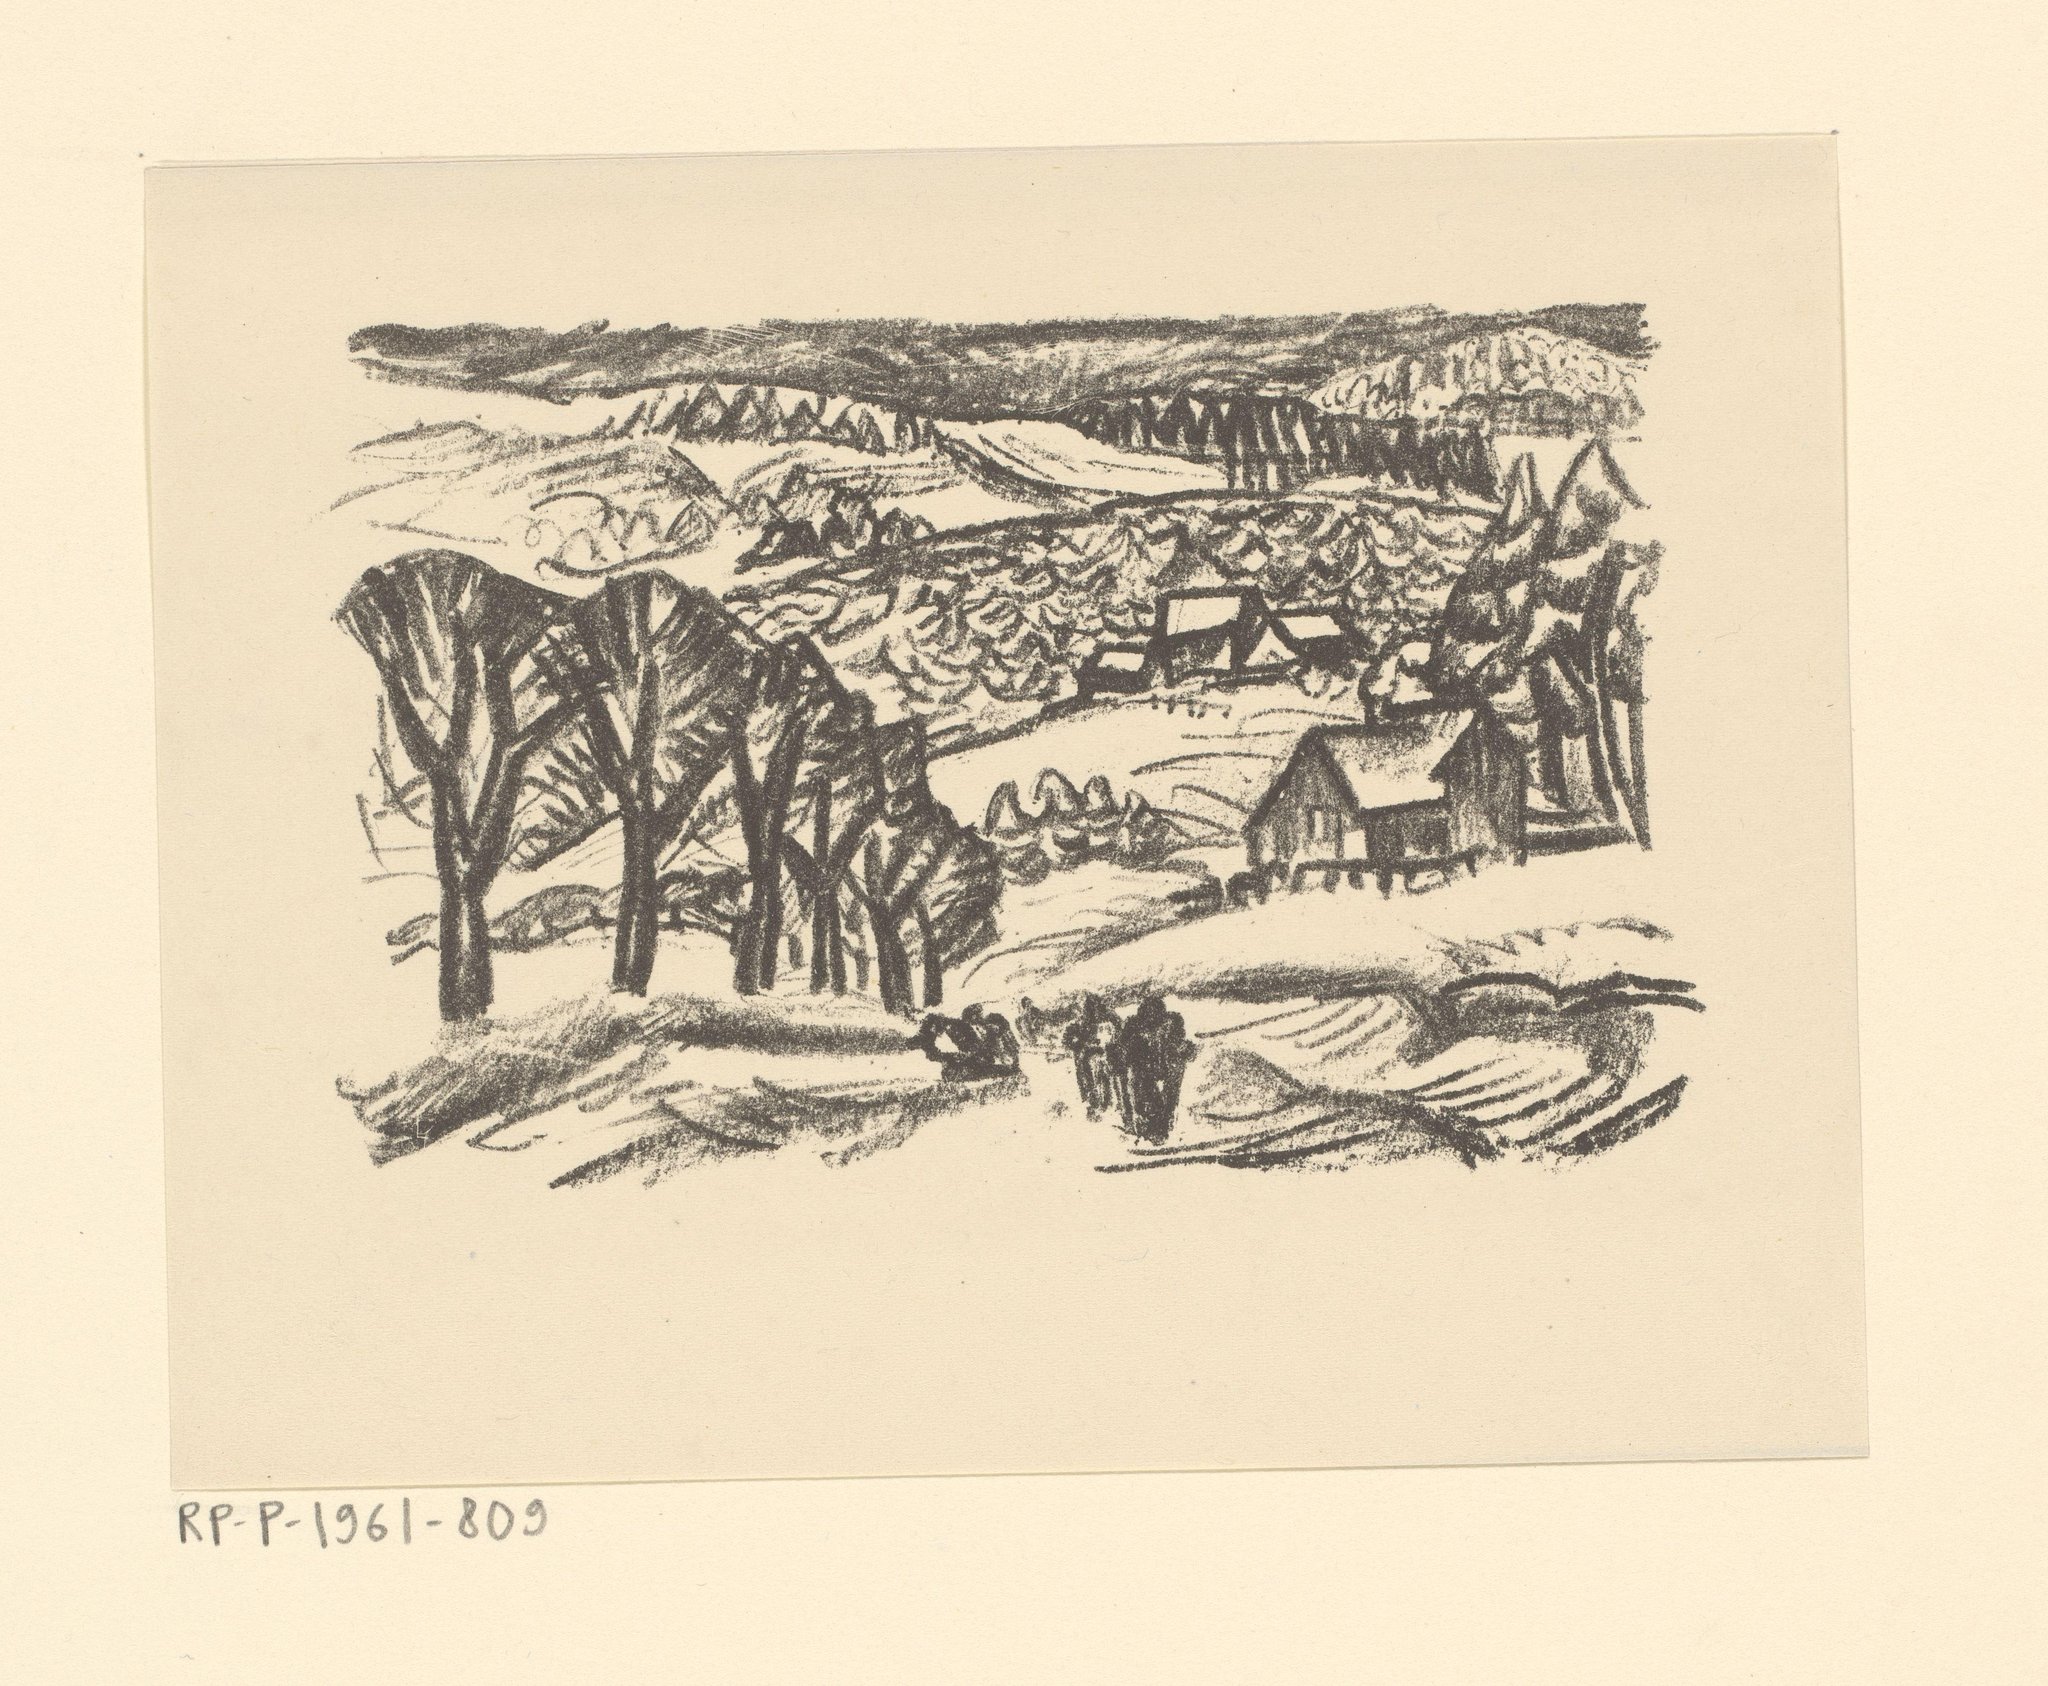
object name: print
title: Besneeuwd heuvellandschap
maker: leo gestel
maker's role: draughtsman, print maker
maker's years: 1881-1941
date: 1923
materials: paper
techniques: lithograph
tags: (high) hill, snow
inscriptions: collector's mark: Lugt 2228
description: Wandelende figuren in een besneeuwd heuvellandschap met huizen en bomen, vermoedelijk het Ertsgebergte in Duitsland.